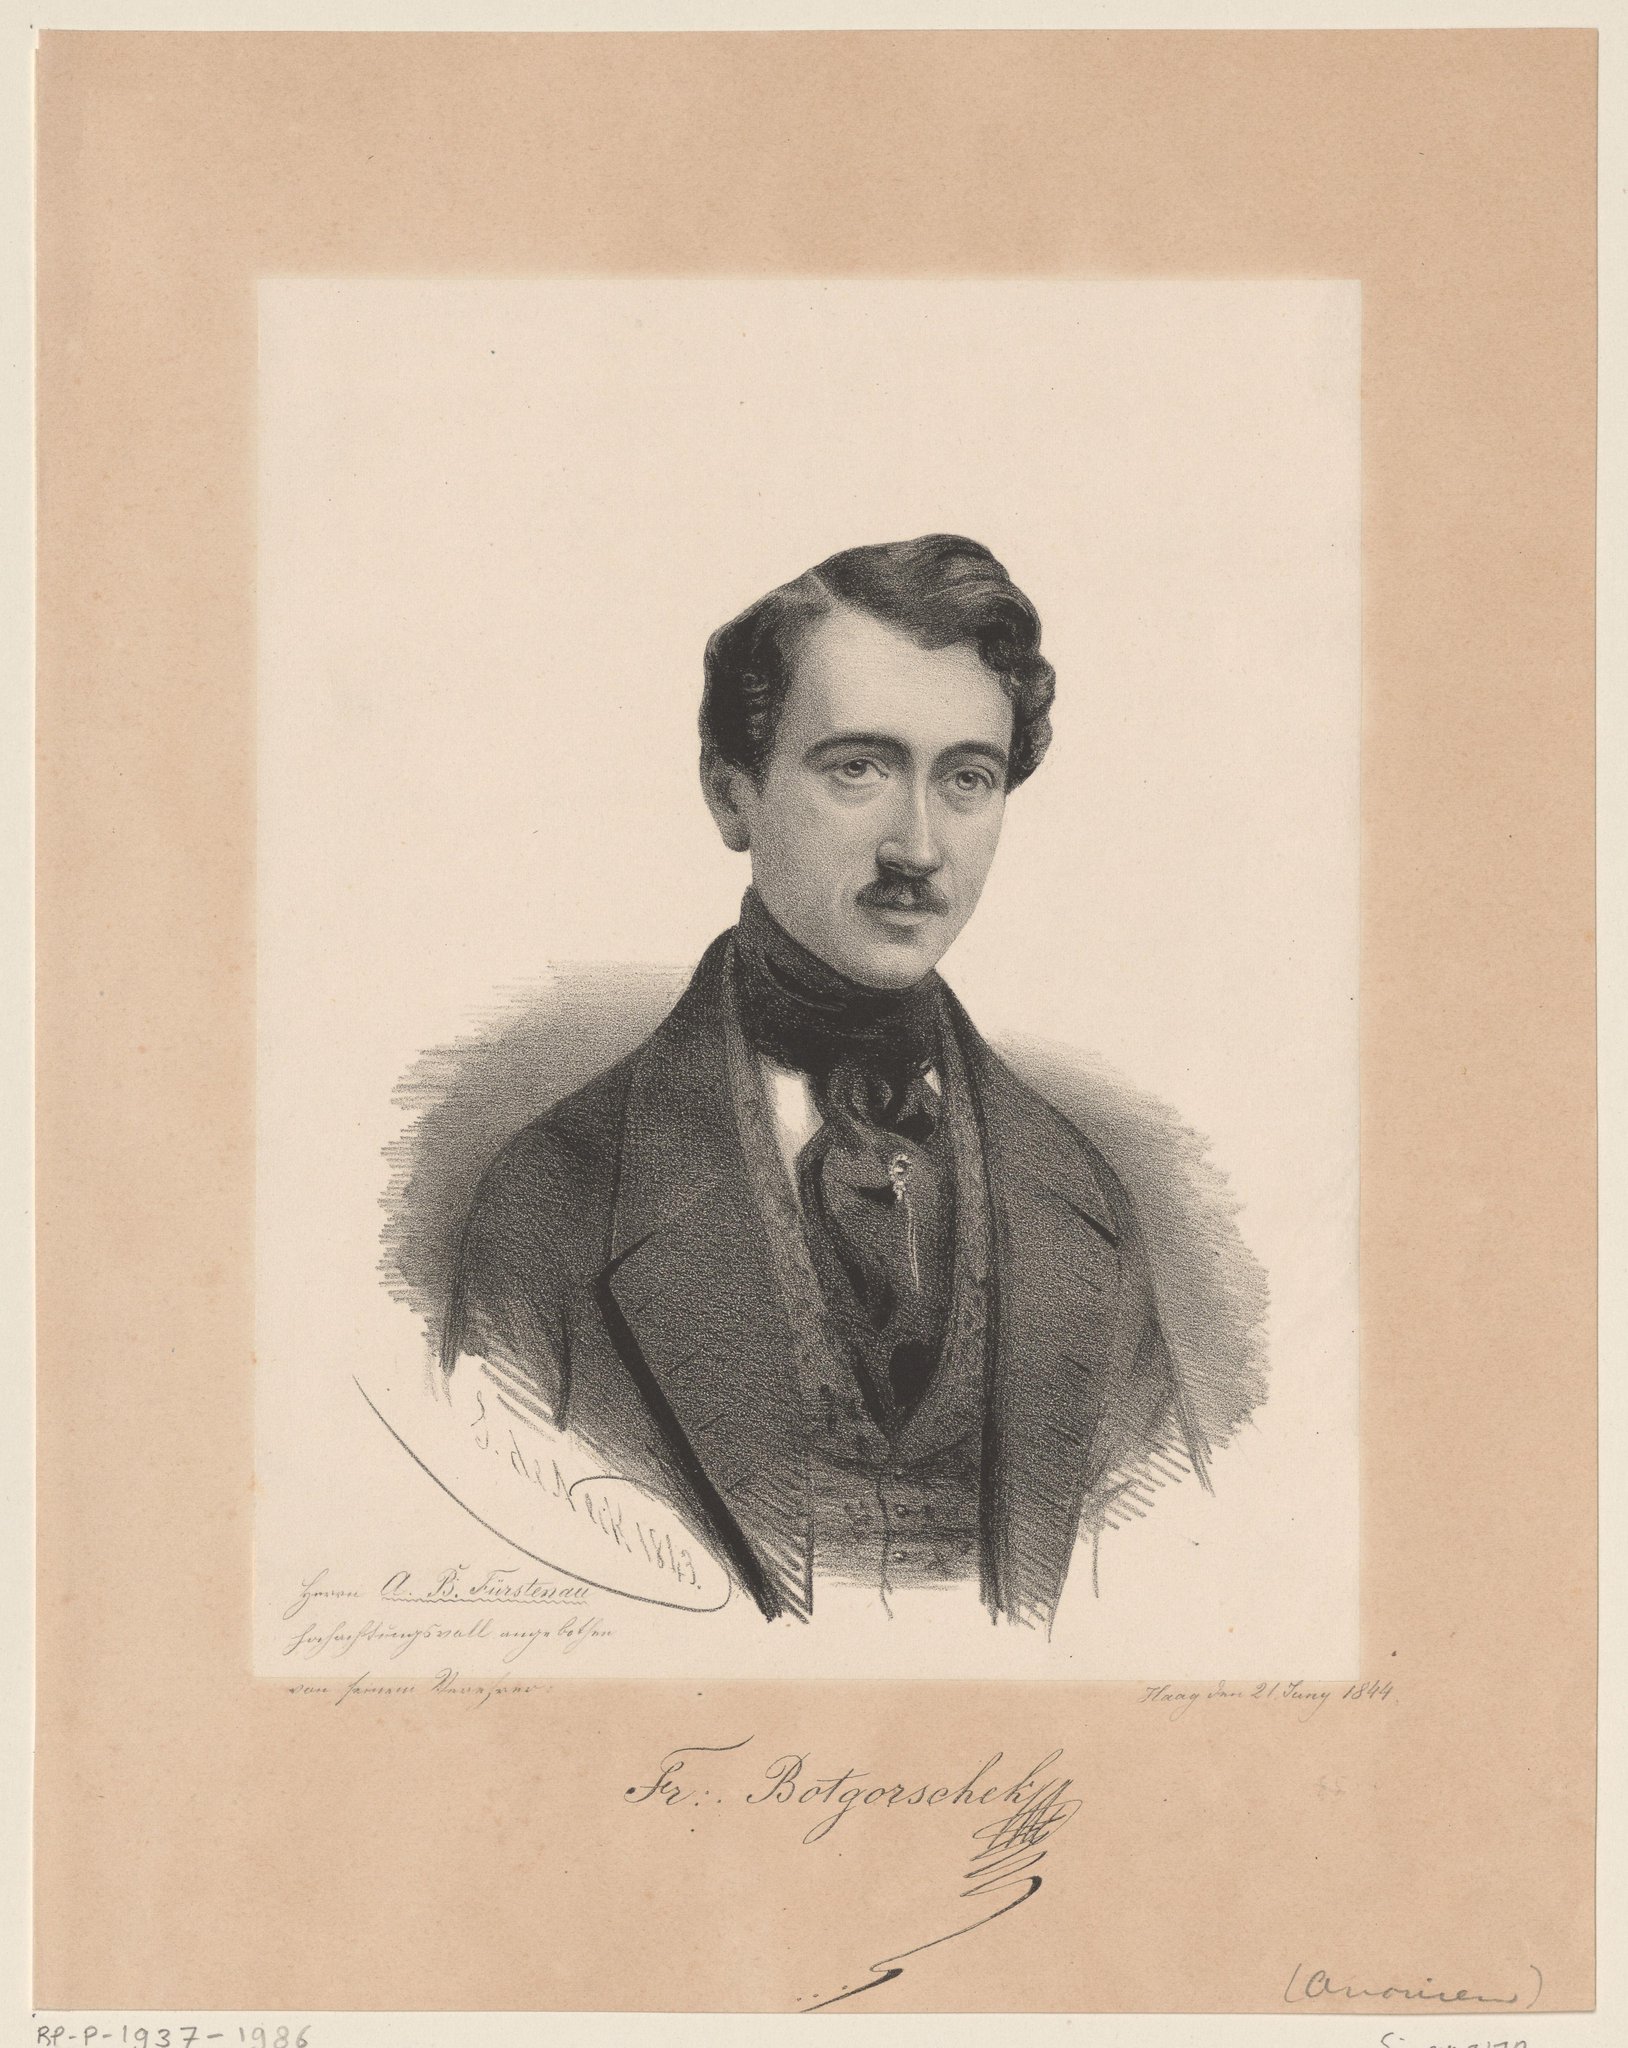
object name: print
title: Portret van Franz Botgorschek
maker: Anonymous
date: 1843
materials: paper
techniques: lithograph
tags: the hague, historical persons, portrait of a musician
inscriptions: collector's mark: Lugt 2228